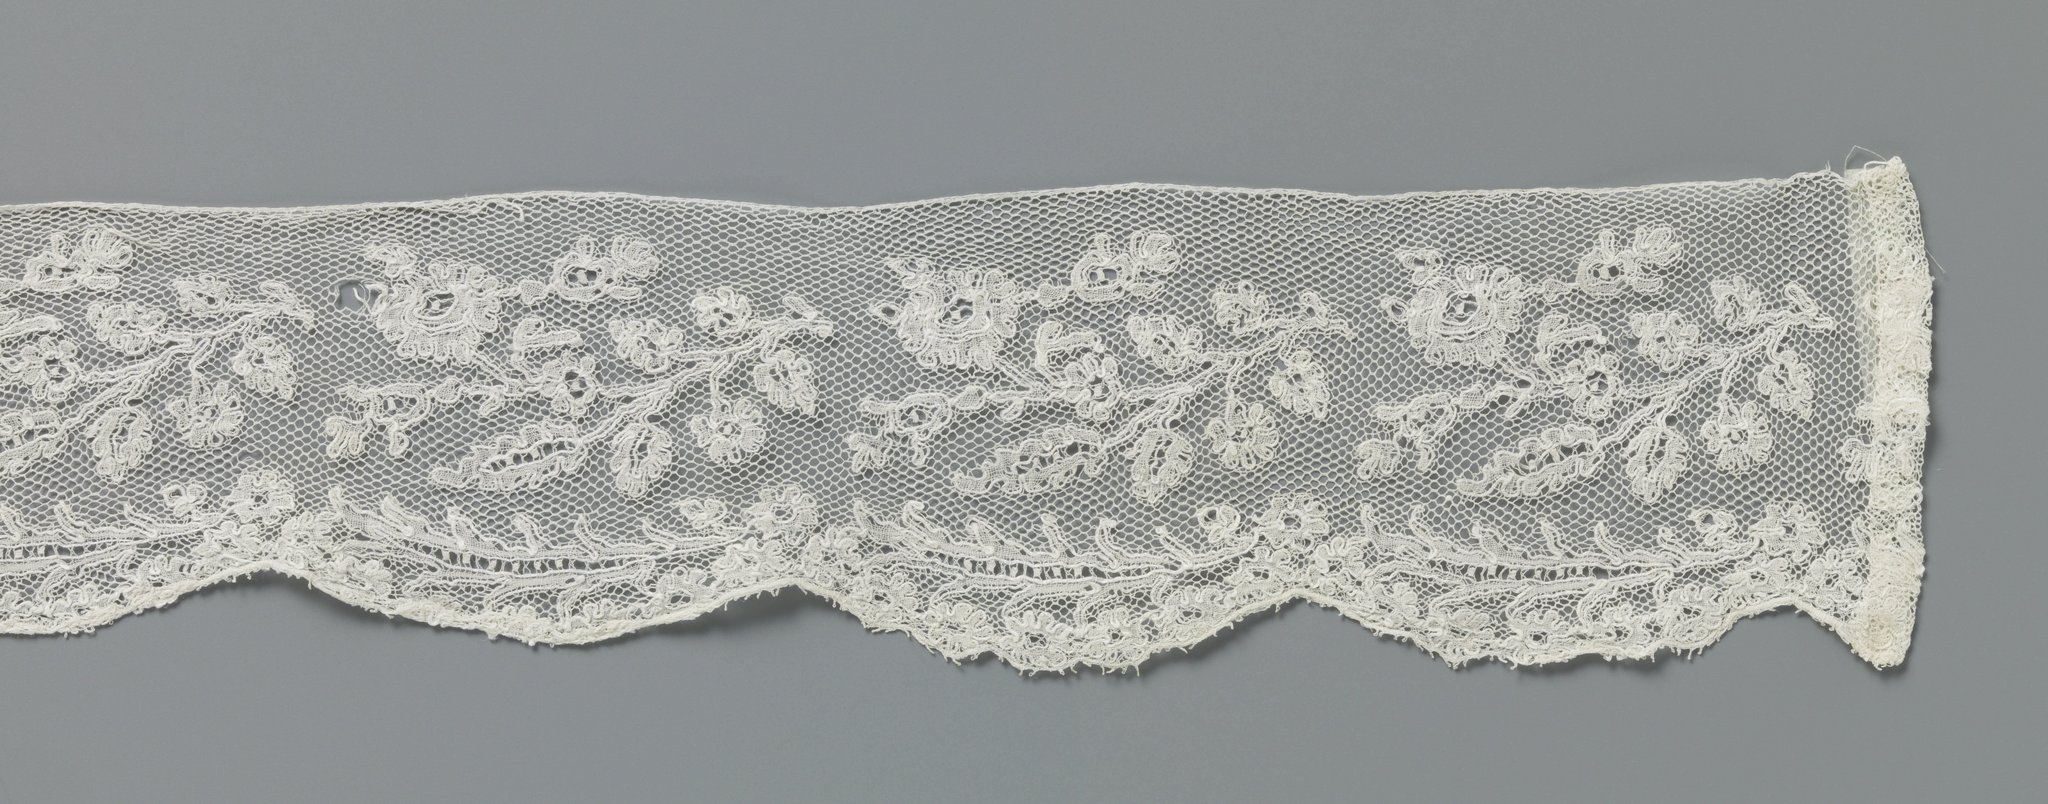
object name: strip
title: Strook kloskant met liggende bloemtak in schulp met rozetbloempjes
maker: Anonymous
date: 1850-1899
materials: linen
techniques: lace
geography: belgium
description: Strook naturelkleurige kloskant: Mechelse kant. Het zich herhalende patroon bestaat uit een liggende bloemtak met verschillende soorten bloemen. Elke opeenvolgende tak ligt recht boven een langgerekt blad in een schulp in een flauw gebogen schulp. Langs de schulpenrand loopt een aaneenschakeling van rozetbloempjes. De motieven zijn met elkaar verbonden door een een fijne maasgrond, een Mechelse grond. De motieven zijn gemaakt in linnenslag met dikkere en glimmende contourdraden. In de opengewerkte bloemharten zijn blokjes gemaakt in vormslag. De bovenzijde van de strook is recht afgewerkt. De schulpenrand is afgewerkt met picots. De korte kanten zijn afgewerkt met een zoompje.